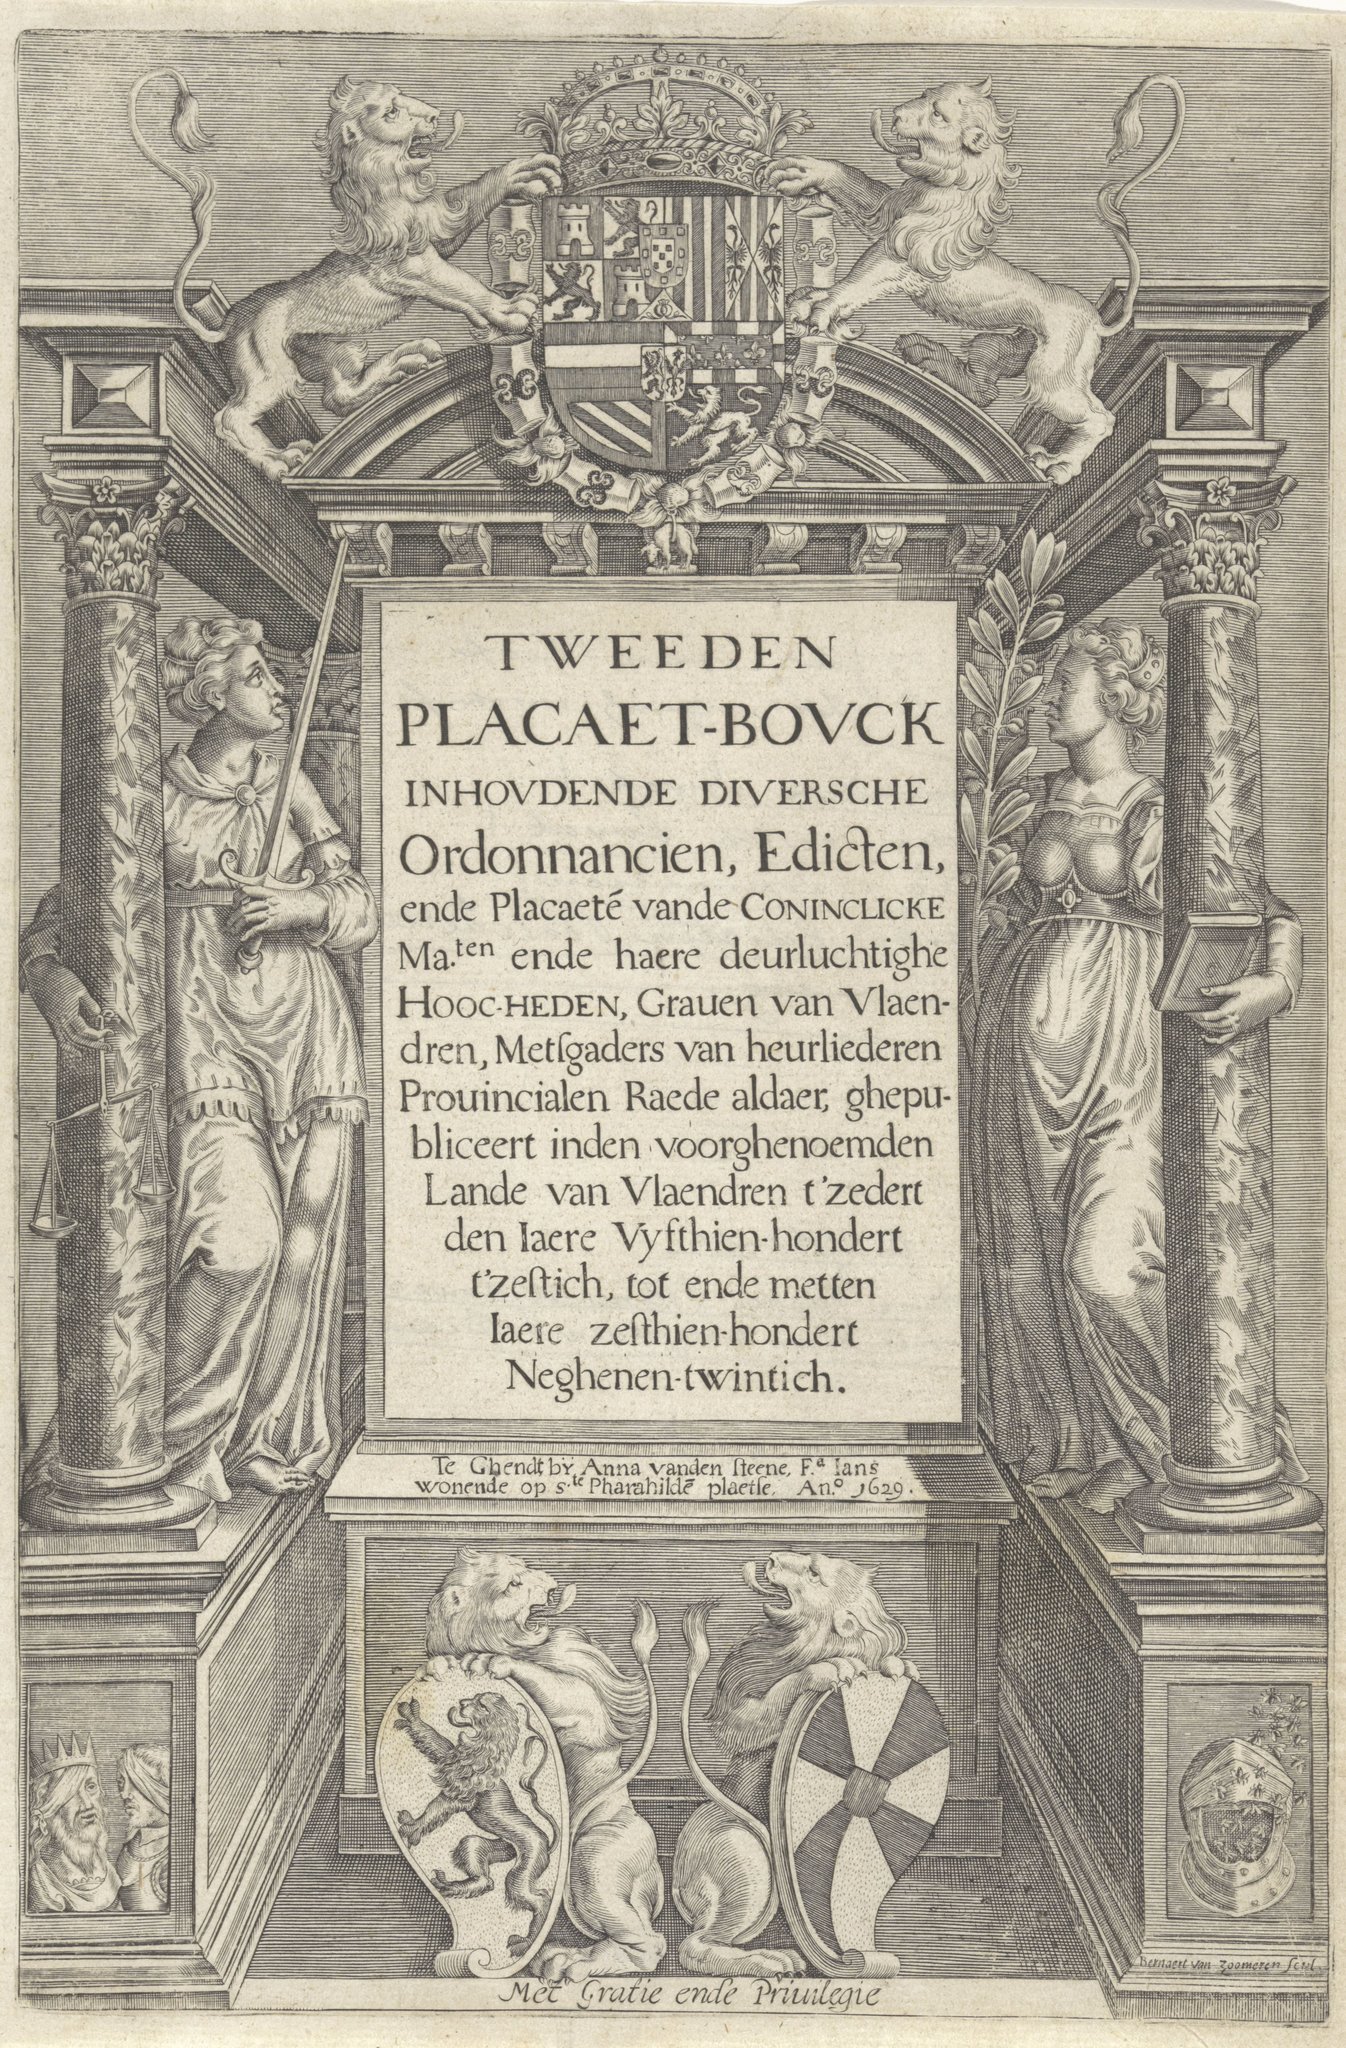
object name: print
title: Titelpagina van: Tweeden Placaet-bouck (...), 1629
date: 1629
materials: paper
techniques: engraving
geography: ghent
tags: justice, 'justitia'; 'giustitia divina' (ripa) ~ one of the four cardinal virtues, faith, 'fides'; 'fede', 'fede catholica', 'fede christiana', 'fede christiana catholica' (ripa) ~ one of the three theological virtues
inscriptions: collector's mark: Lugt 2228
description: Titelpagina van: Tweeden Placaet-bouck inhoudende diversche ordonnancien, edicten, ende placaete[n] vande (...) Graven van Vlaenderen (...) ghepubliceert (...) zedert den iaere vijfthien-hondert t'zestich, tot ende metten (...) zesthien-hondert neghenen-twintich. Gent: Anna van den Steene, 1629.